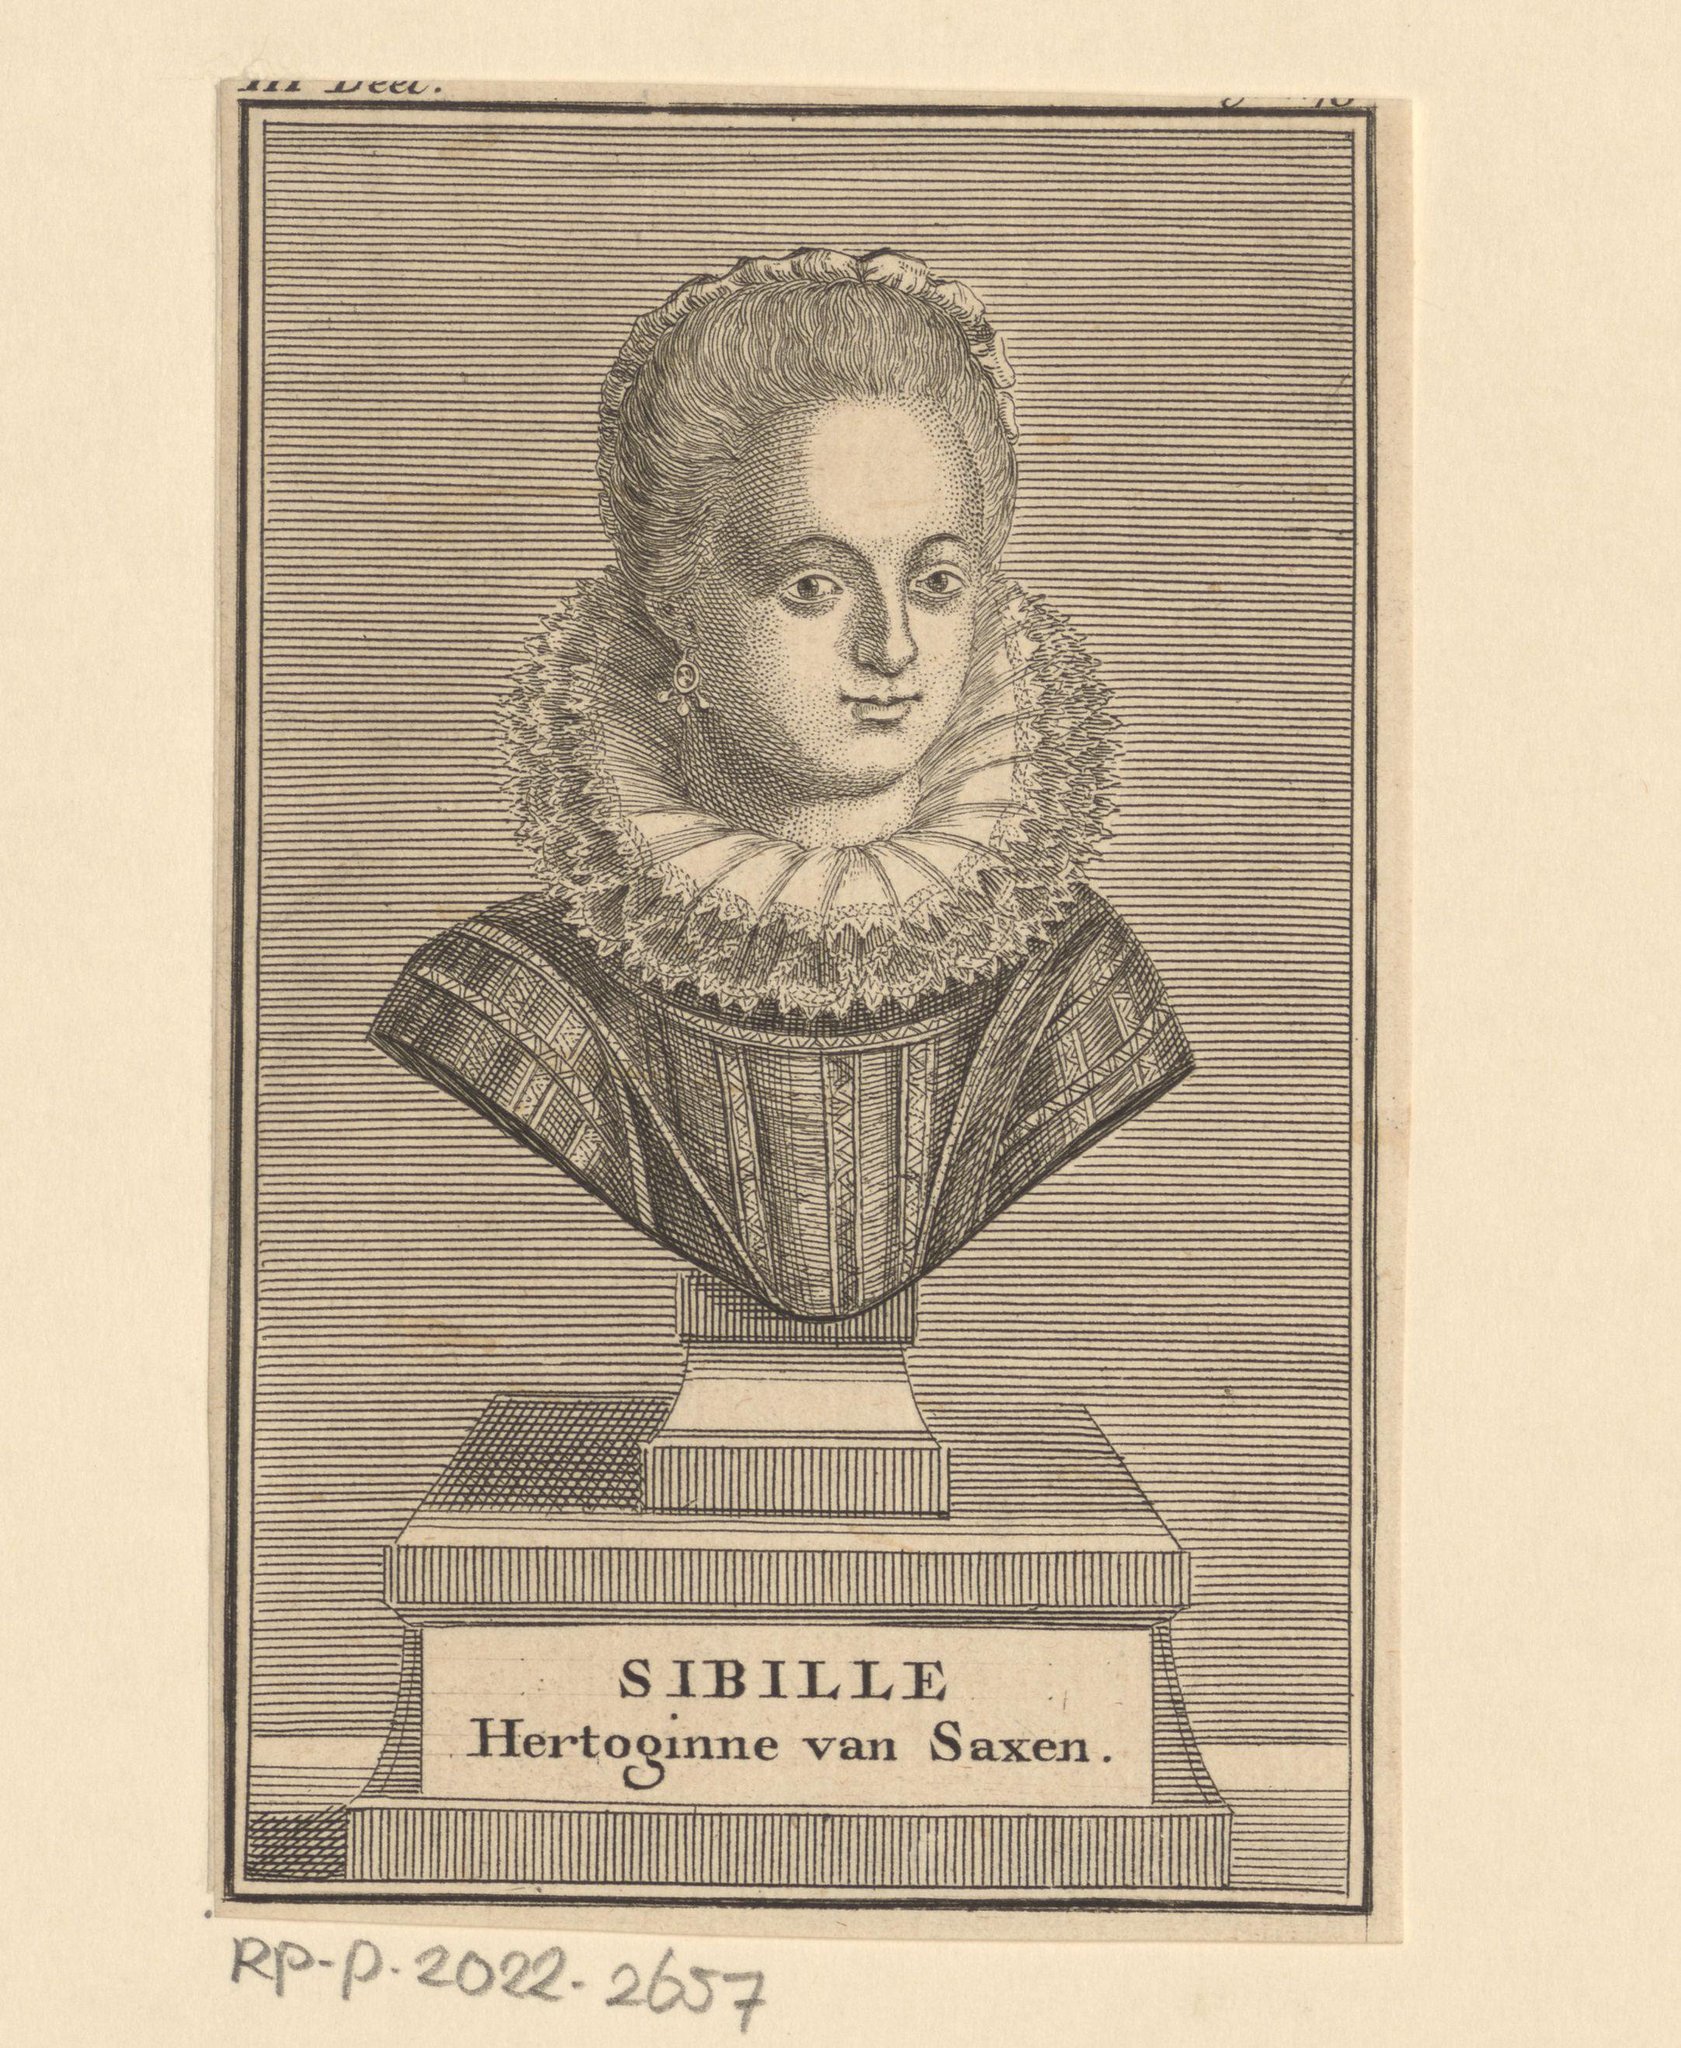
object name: print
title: Portret van Sibylla van Kleef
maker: Anonymous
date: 1738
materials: paper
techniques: etching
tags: other sovereign - bb - female ruler, historical persons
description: Prent waarschijnlijk uit: Leti, Gregorio. Het leven van keizer Karel, den Vyfden. Leiden en Amsterdam: J. en H. van der Deyster en J. Roman de jonge, 1738, dl. 3.